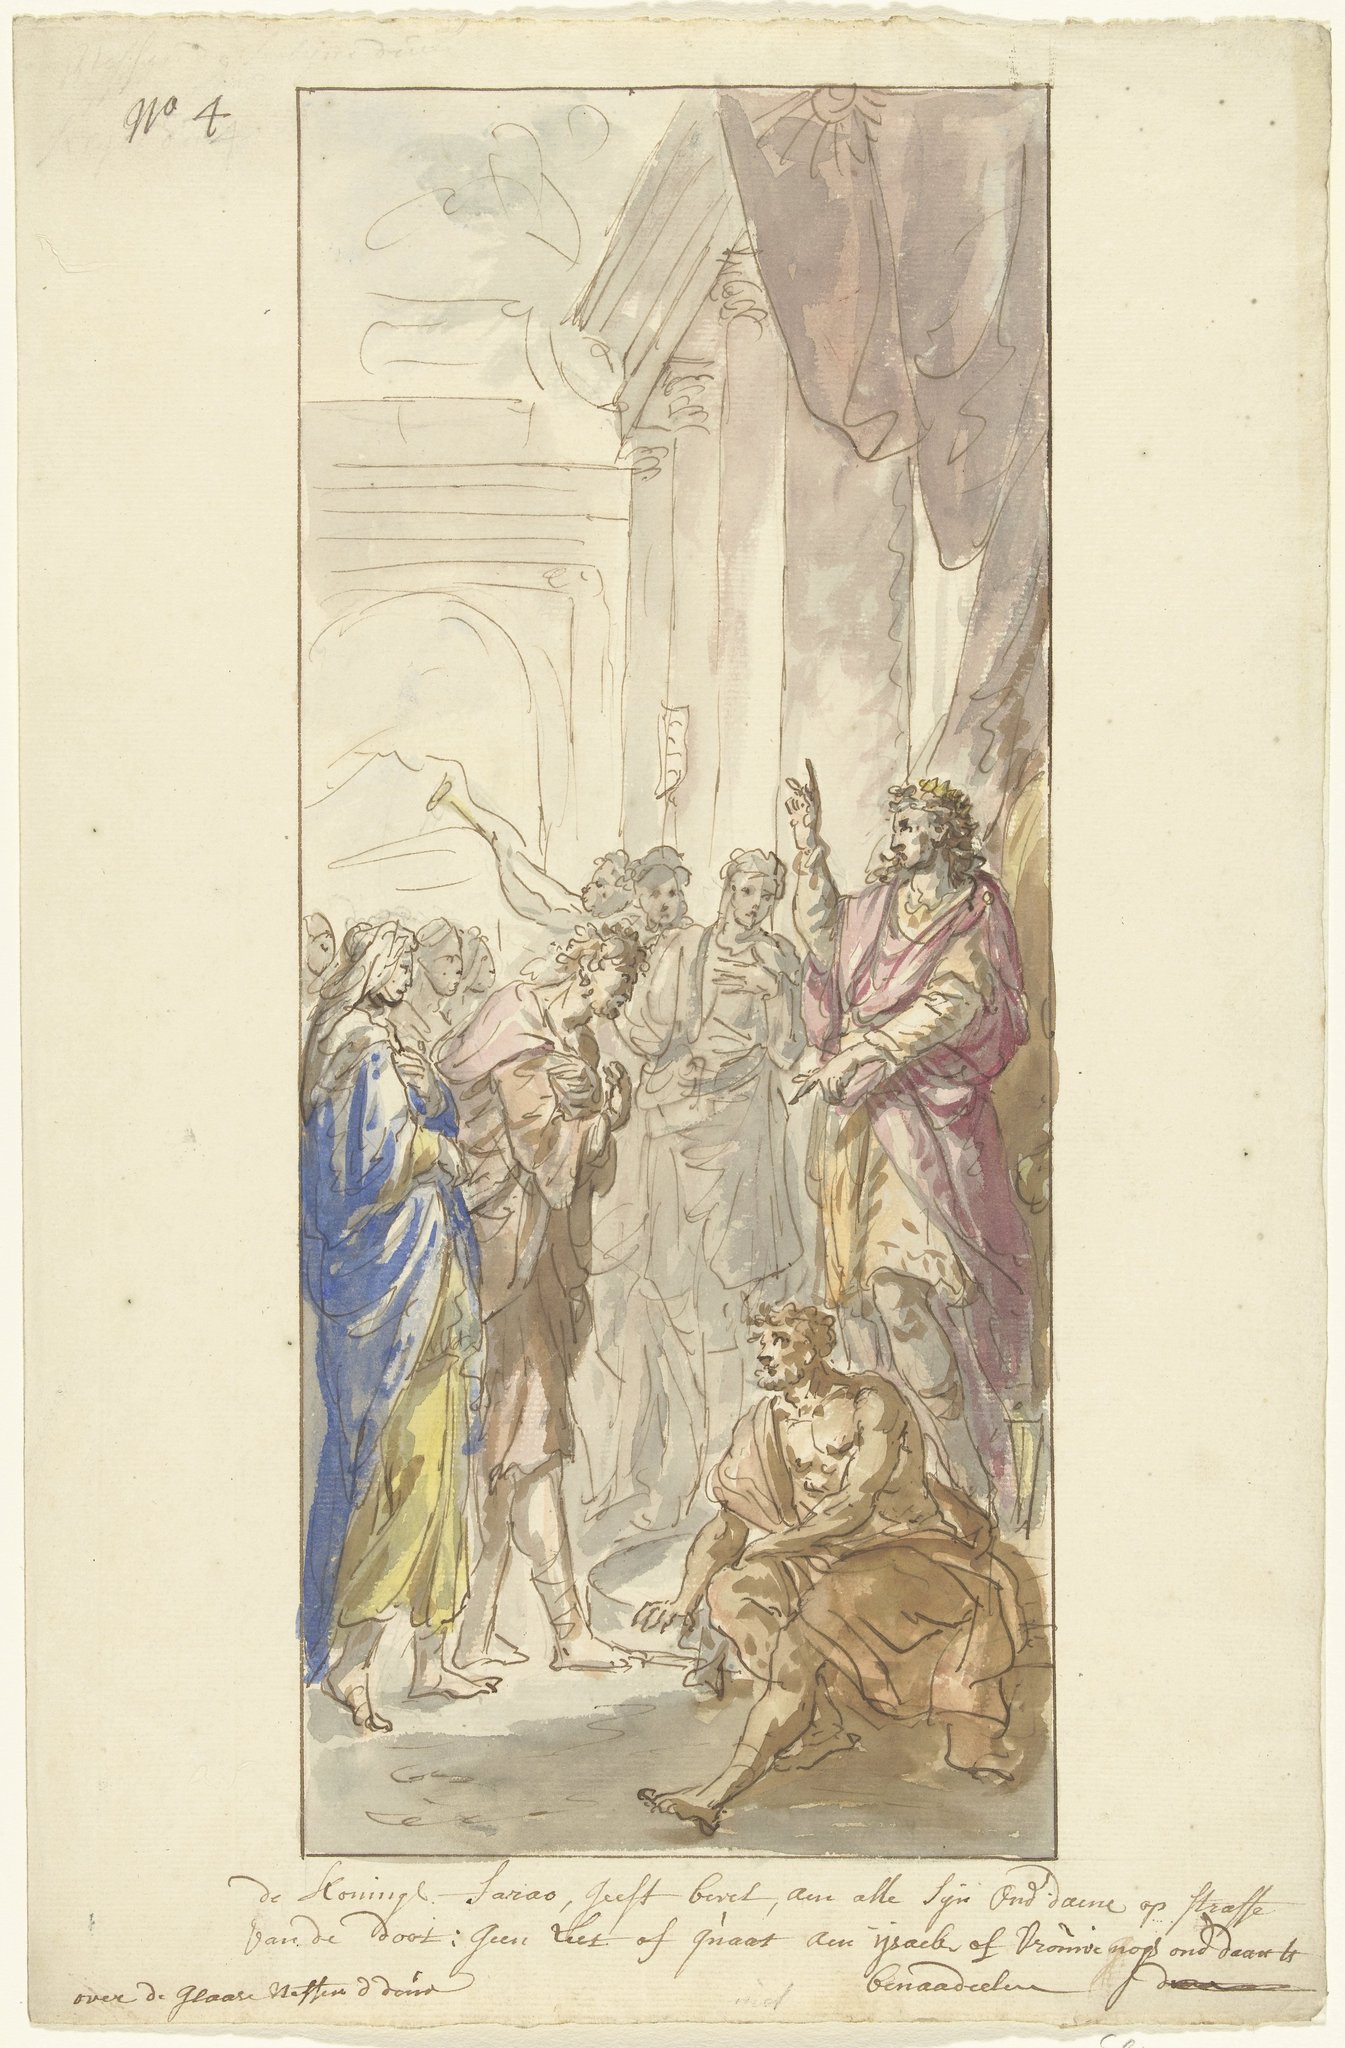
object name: design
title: Izaäk en Rebekka voor Abimelech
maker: elias van nijmegen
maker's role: draughtsman, painter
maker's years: 1667-1755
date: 1677-1755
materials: ink, paper, pencil, watercolor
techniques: brush, pen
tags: isaac and rebekah before abimelech